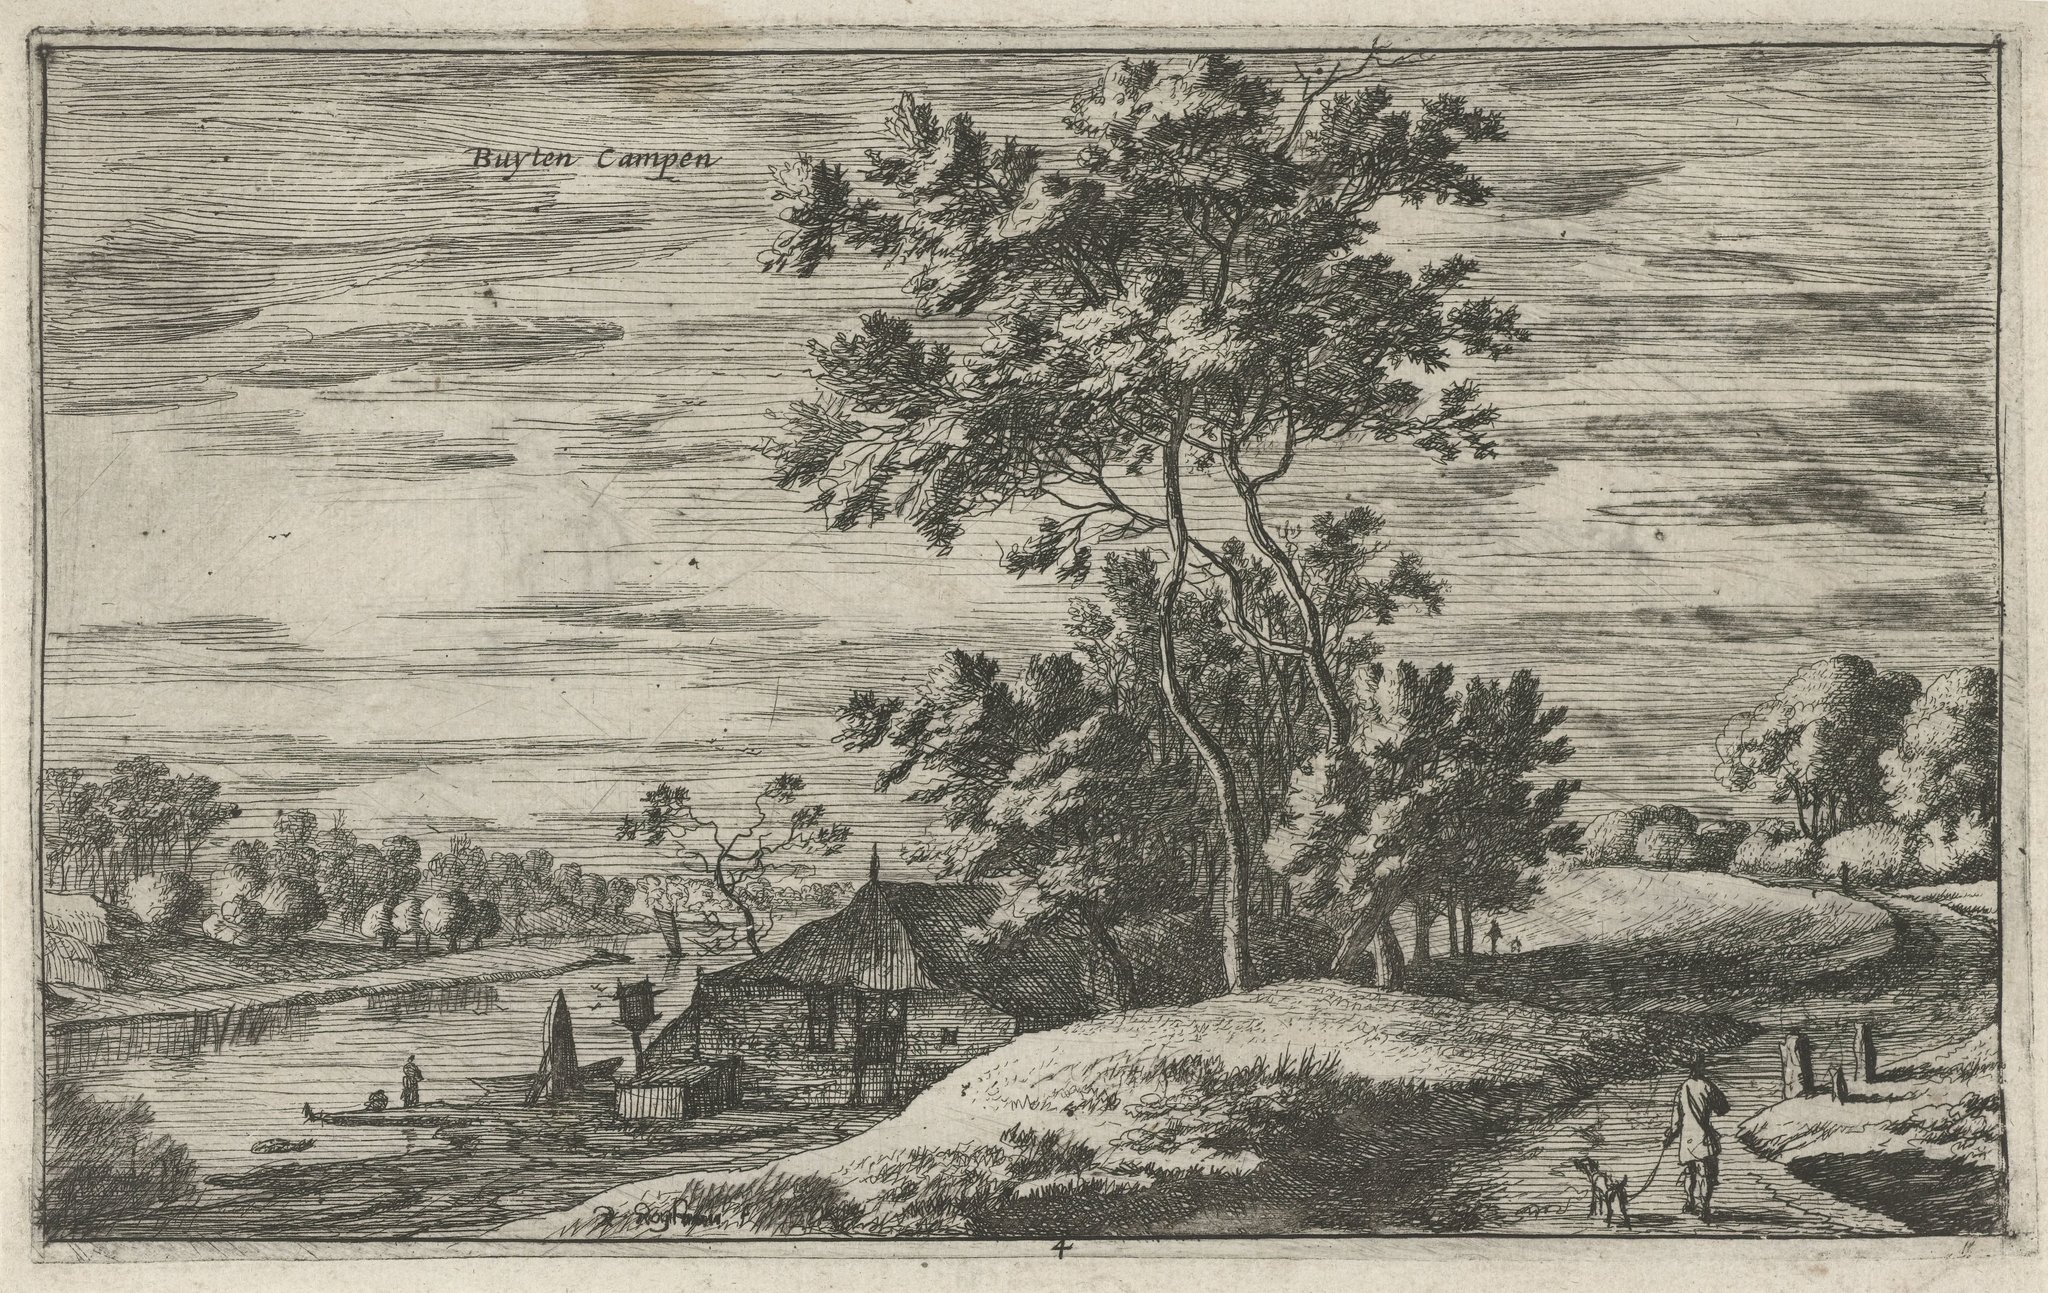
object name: print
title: Gezicht op de IJssel bij Kampen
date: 1637-1677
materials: paper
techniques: drypoint, etching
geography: amsterdam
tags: dove-cote, dikes, levee, farm or solitary house in landscape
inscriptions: collector's mark: Lugt 240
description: Gezicht op de rivier de IJssel, in de omgeving van de stad Kampen. Aan de IJssel ligt een hoeve met een duiventil. Over de dijk loopt een slingerweg waarop een man met een hond wandelt. Genummerd onderaan in de marge: 4.